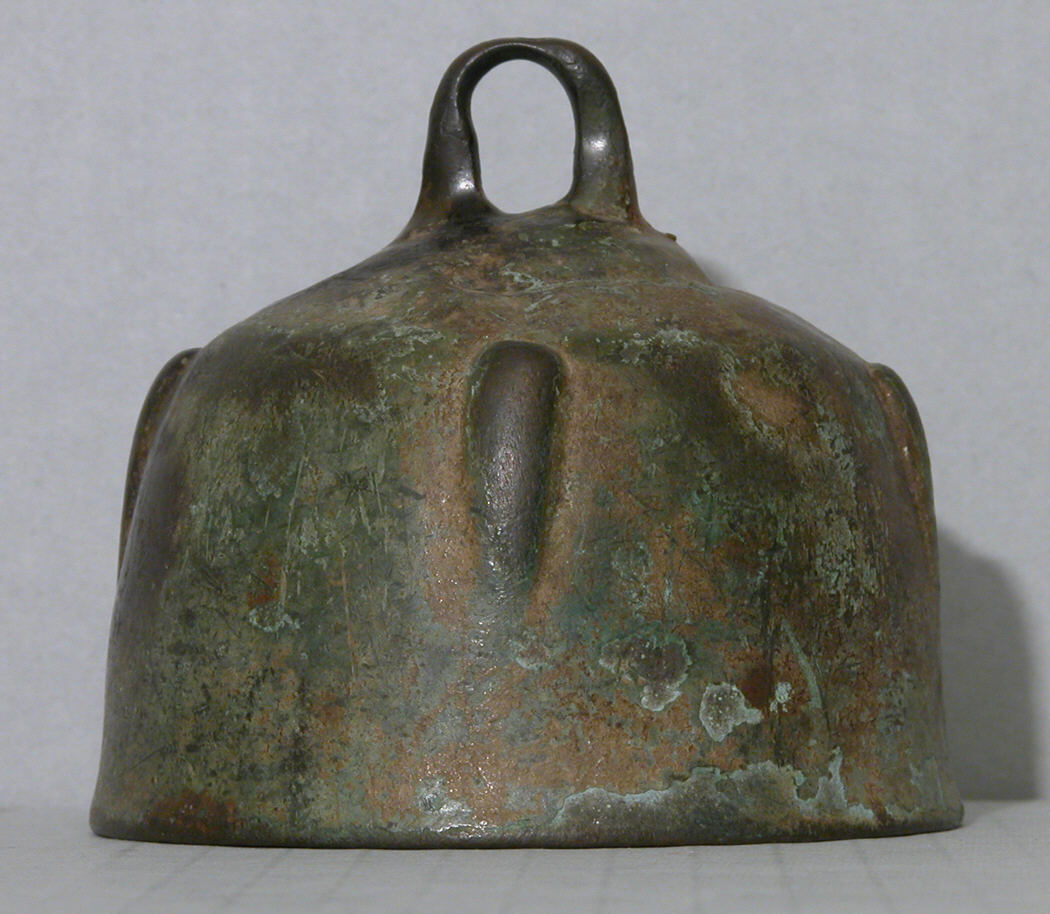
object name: bell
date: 1001-1100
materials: brass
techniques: casting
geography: iran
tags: musical instruments